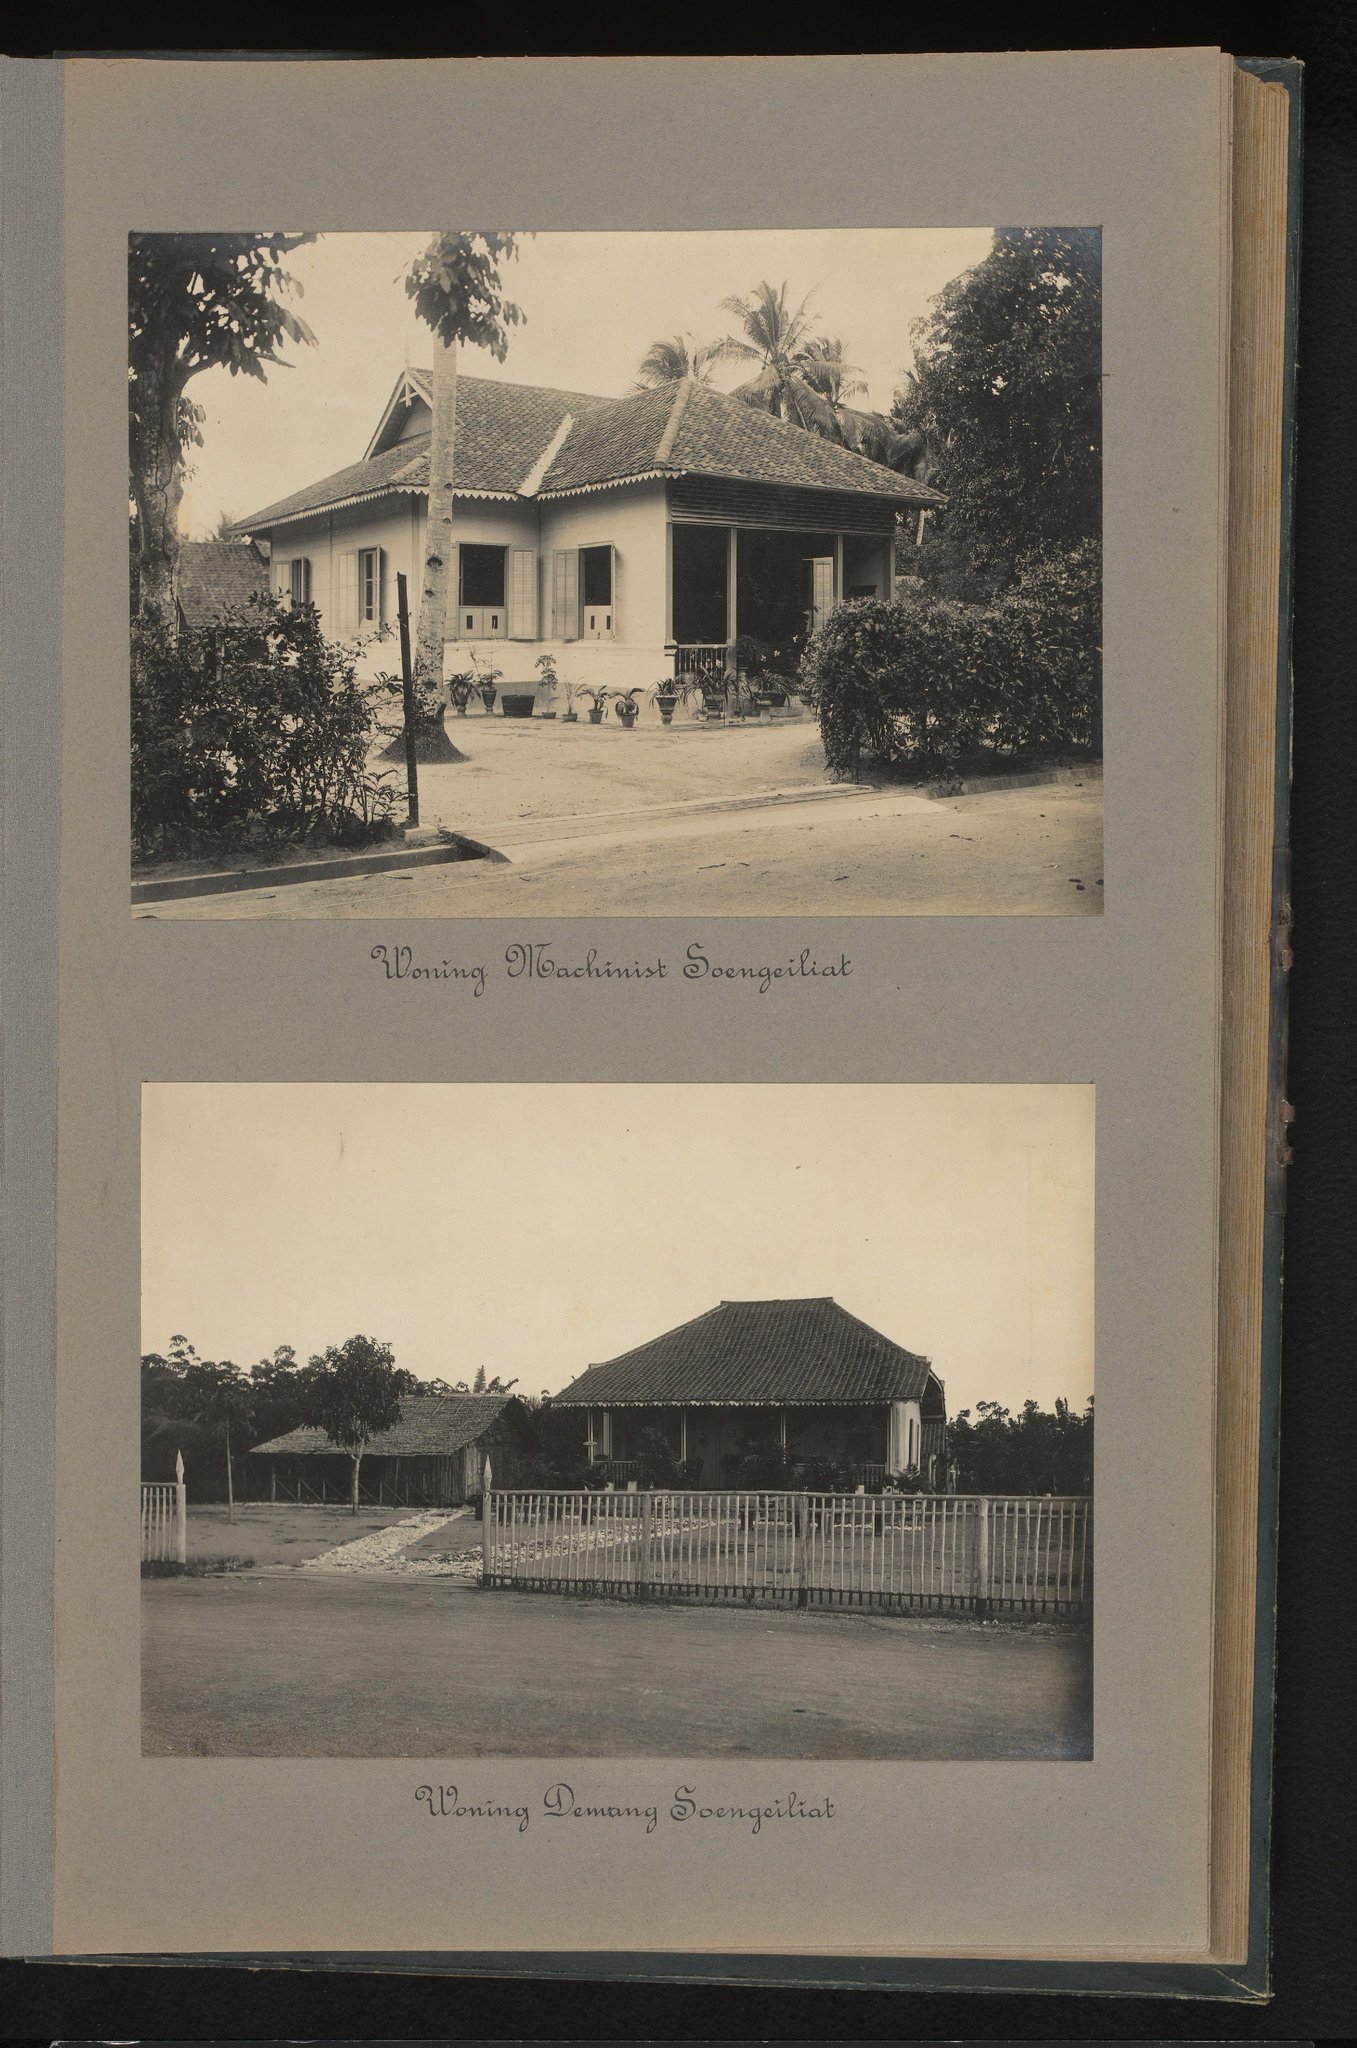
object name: photograph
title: Woningen van de Banka-tinwinning te Soengeiliat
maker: Anonymous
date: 1914-1919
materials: cardboard, photographic support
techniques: gelatin silver print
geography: bangka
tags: robert julius boers, colonial system, mining, villa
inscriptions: inscription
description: Albumblad met 2 foto's van woningen van de Banka-tinwinning te Soengeiliat. Onderdeel van het fotoalbum aangeboden aan Robert Julius Boers bij zijn vertrek naar Nederland in 1919 door het personeel van de Banka-tinwinning.